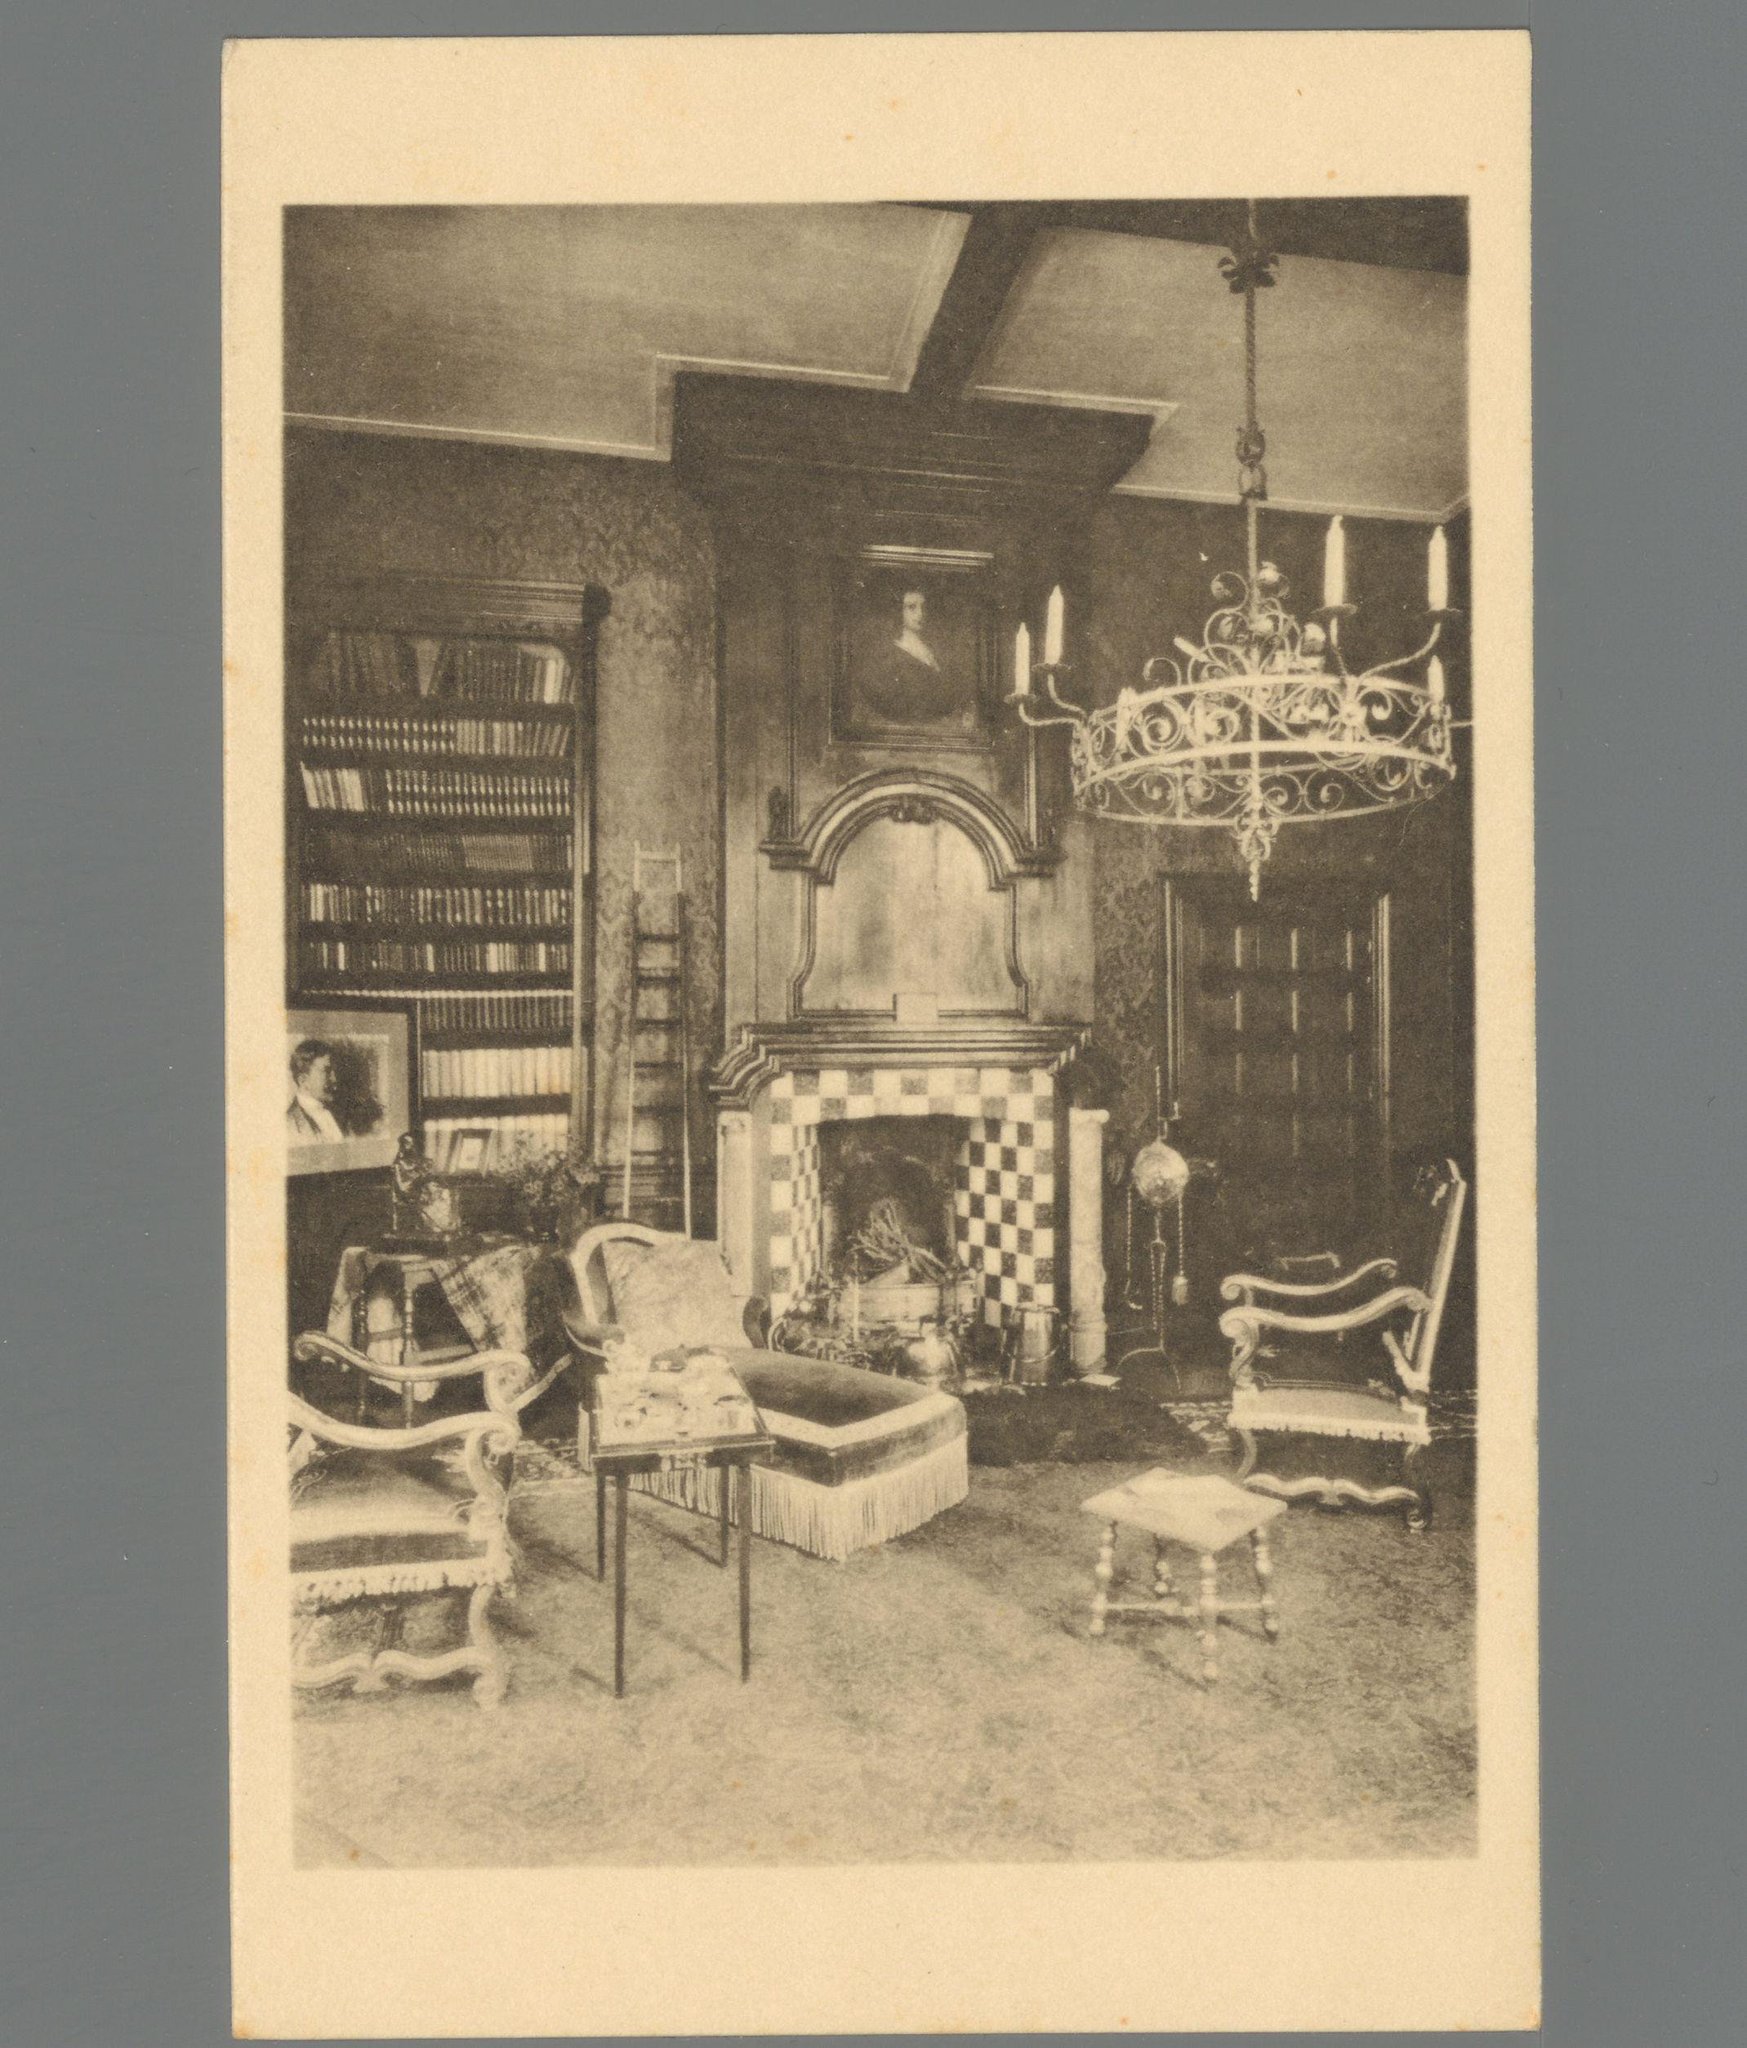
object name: ansichtkaart, prentbriefkaart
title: De Zonheuvel: Boekerij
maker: Anonymous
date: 1913-1950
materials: cardboard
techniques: photograph, writing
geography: doorn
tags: bookshelves, open hearth, fire-place, villa